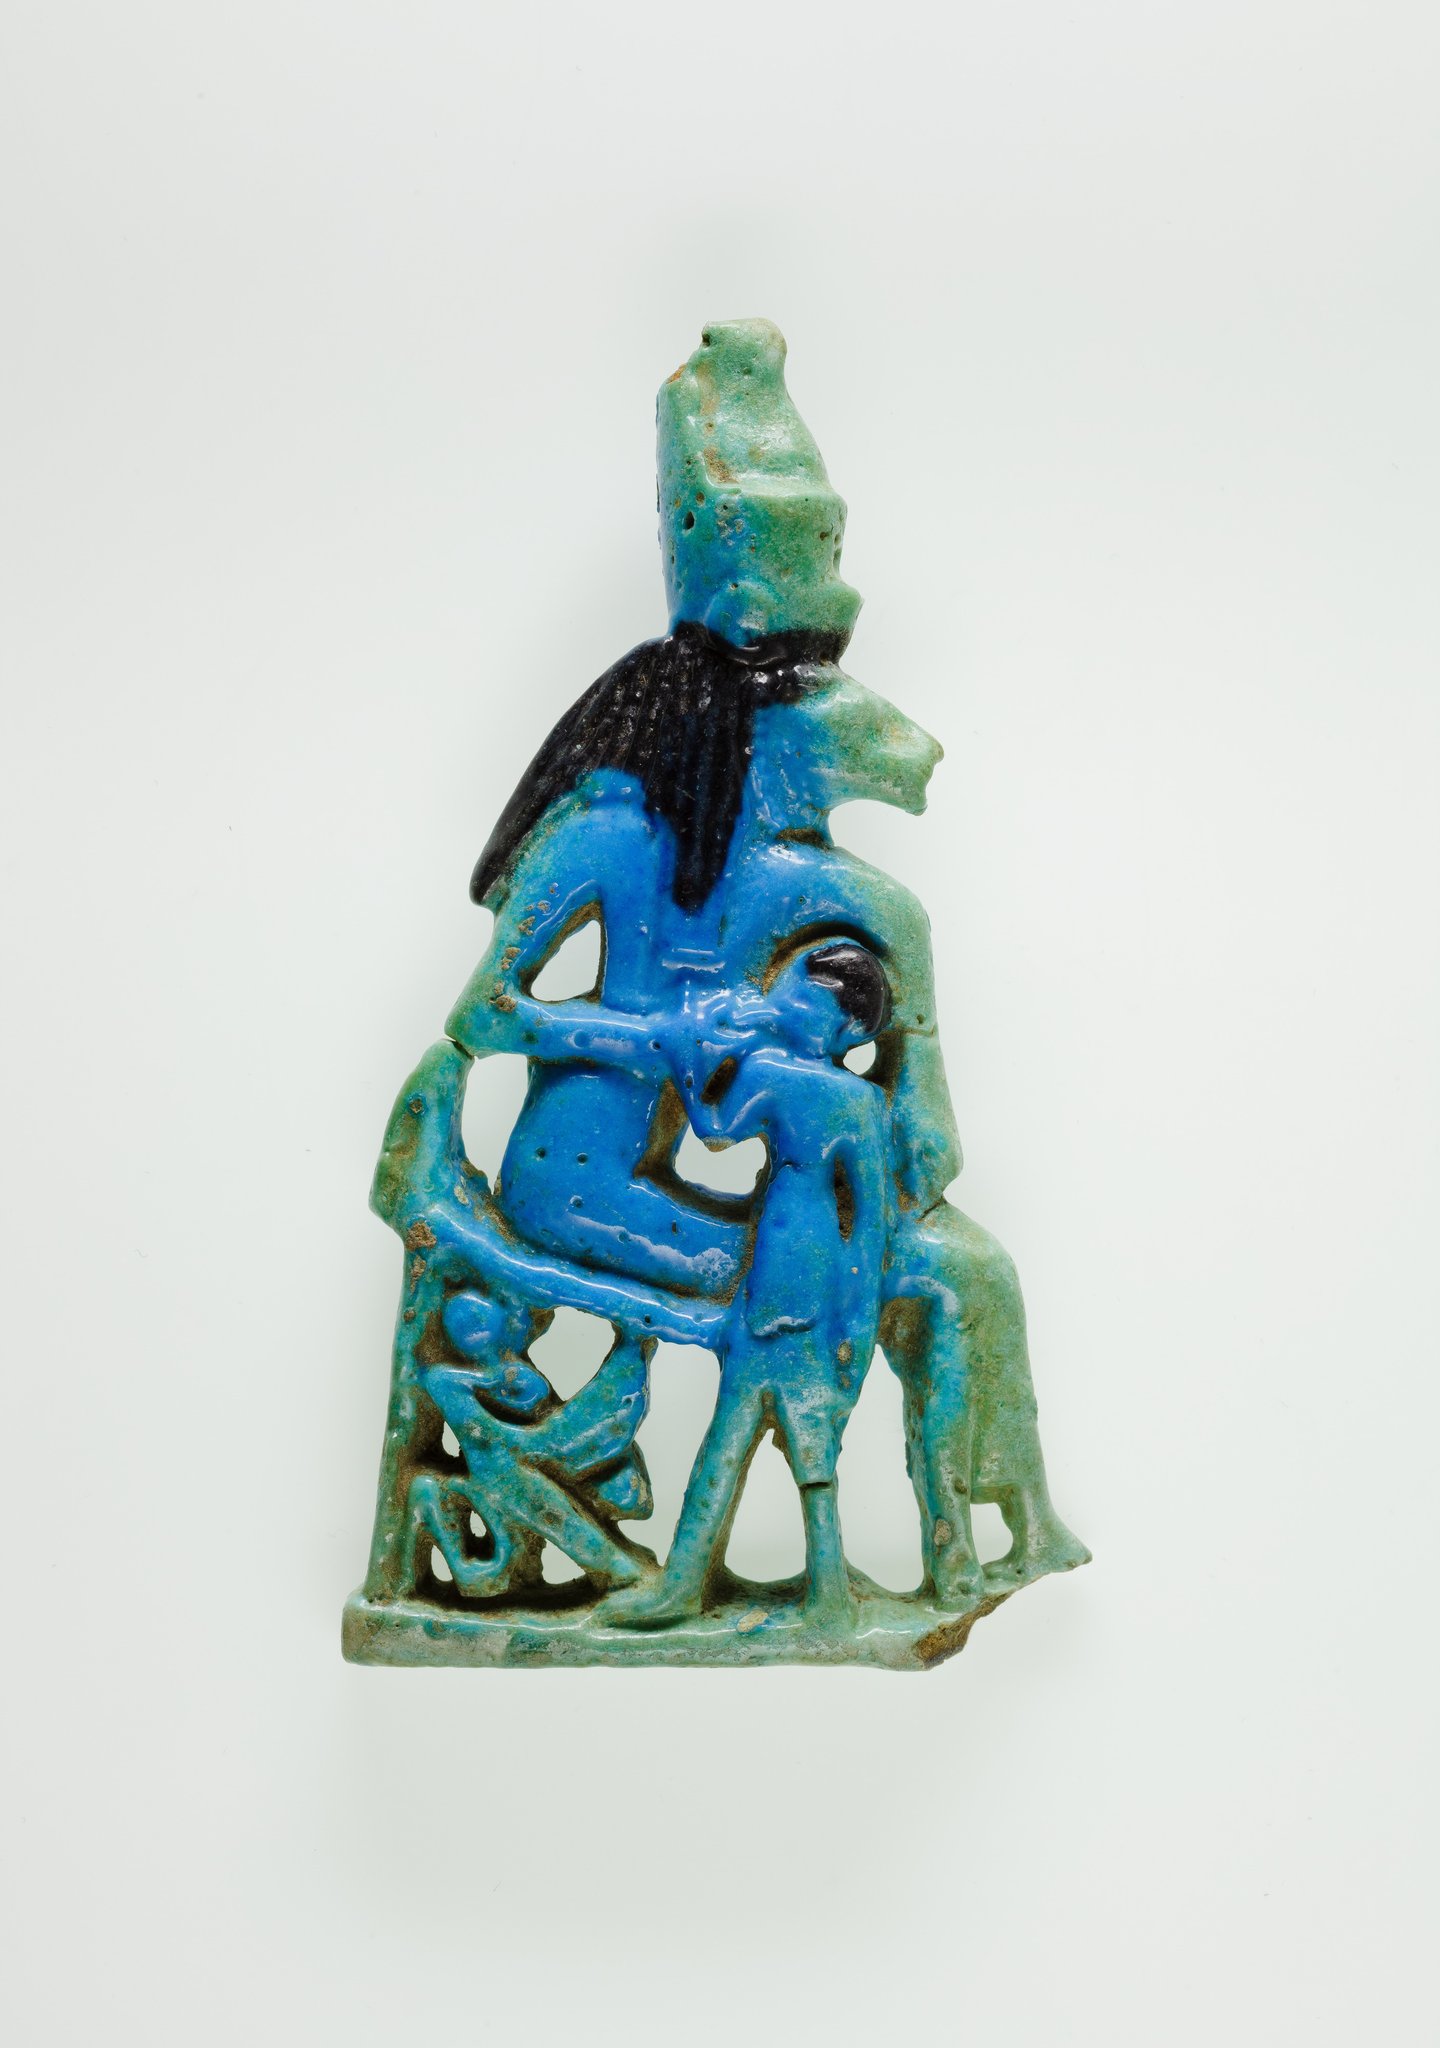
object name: lion headed goddess suckling the king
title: Lion-headed goddess suckling the king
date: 707-664 BCE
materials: faience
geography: egypt or nubia